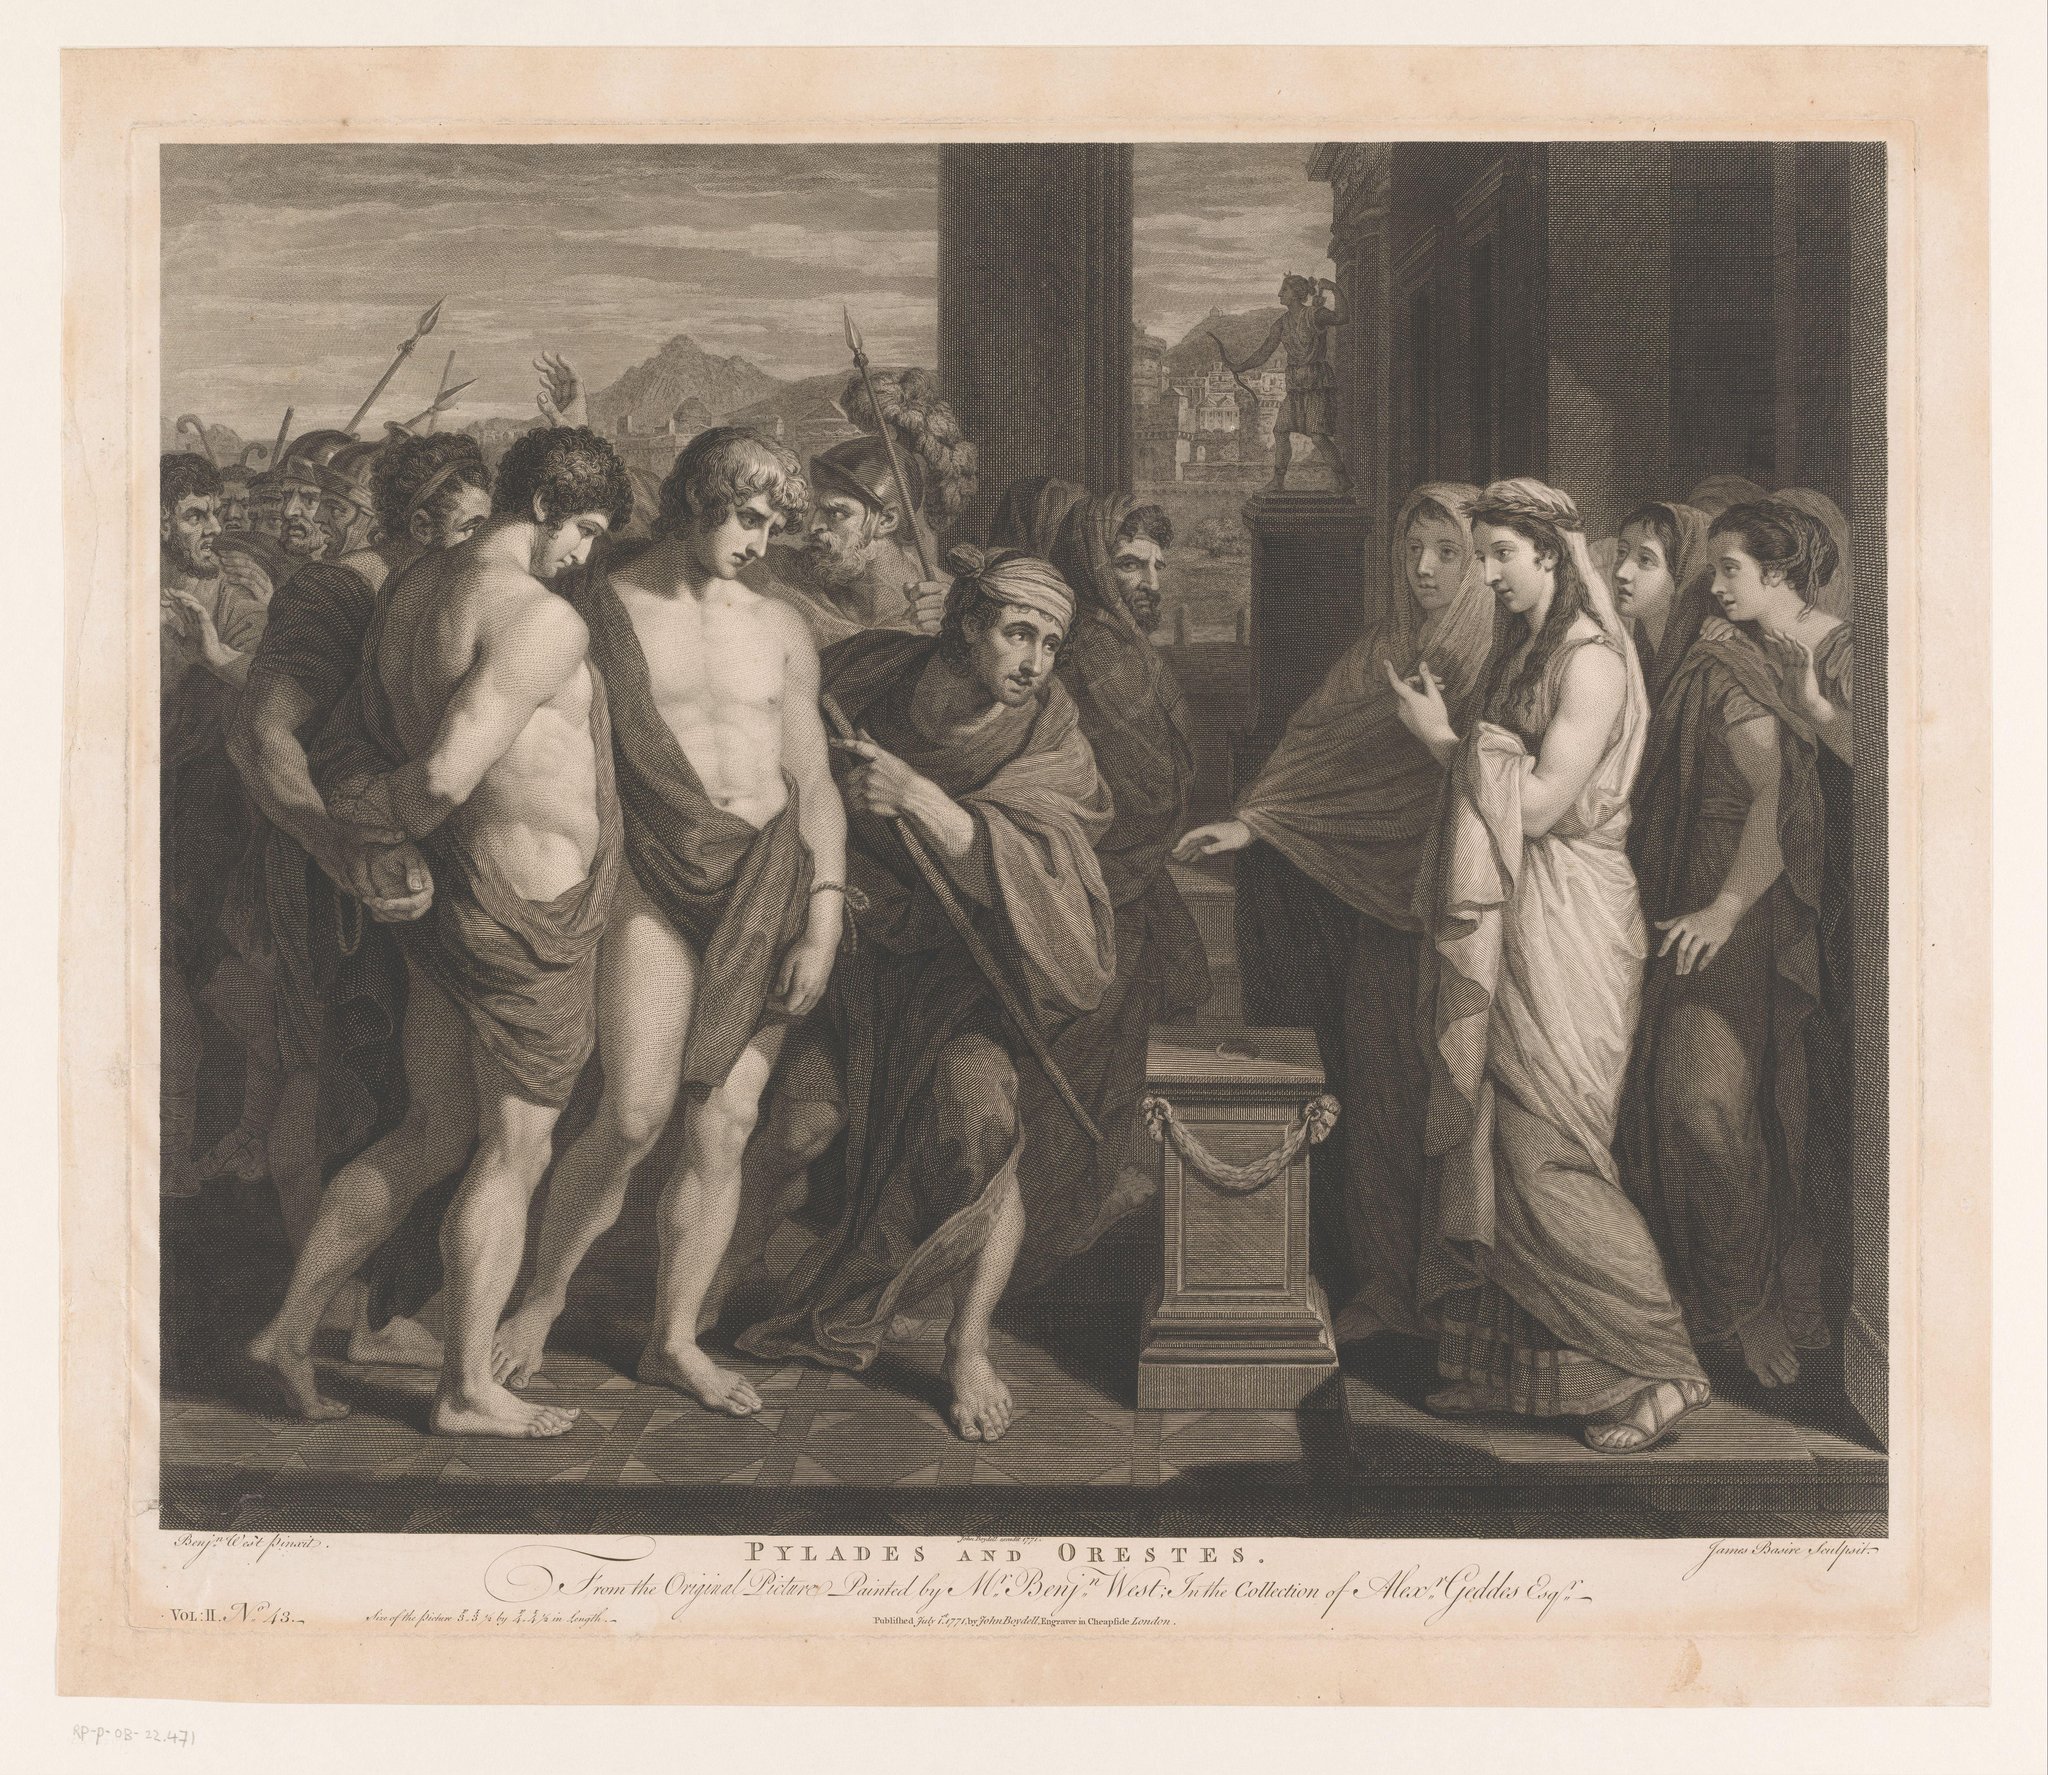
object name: print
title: Pylades en Orestes in Mycene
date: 1771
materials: paper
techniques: engraving, etching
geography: london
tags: orestes and pylades in mycenae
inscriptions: collector's mark: Lugt 12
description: Prent hoort bij de serie 'The Most Capital Paintings in England', tussen 1763 en 1786 gepubliceerd door John Boydell.